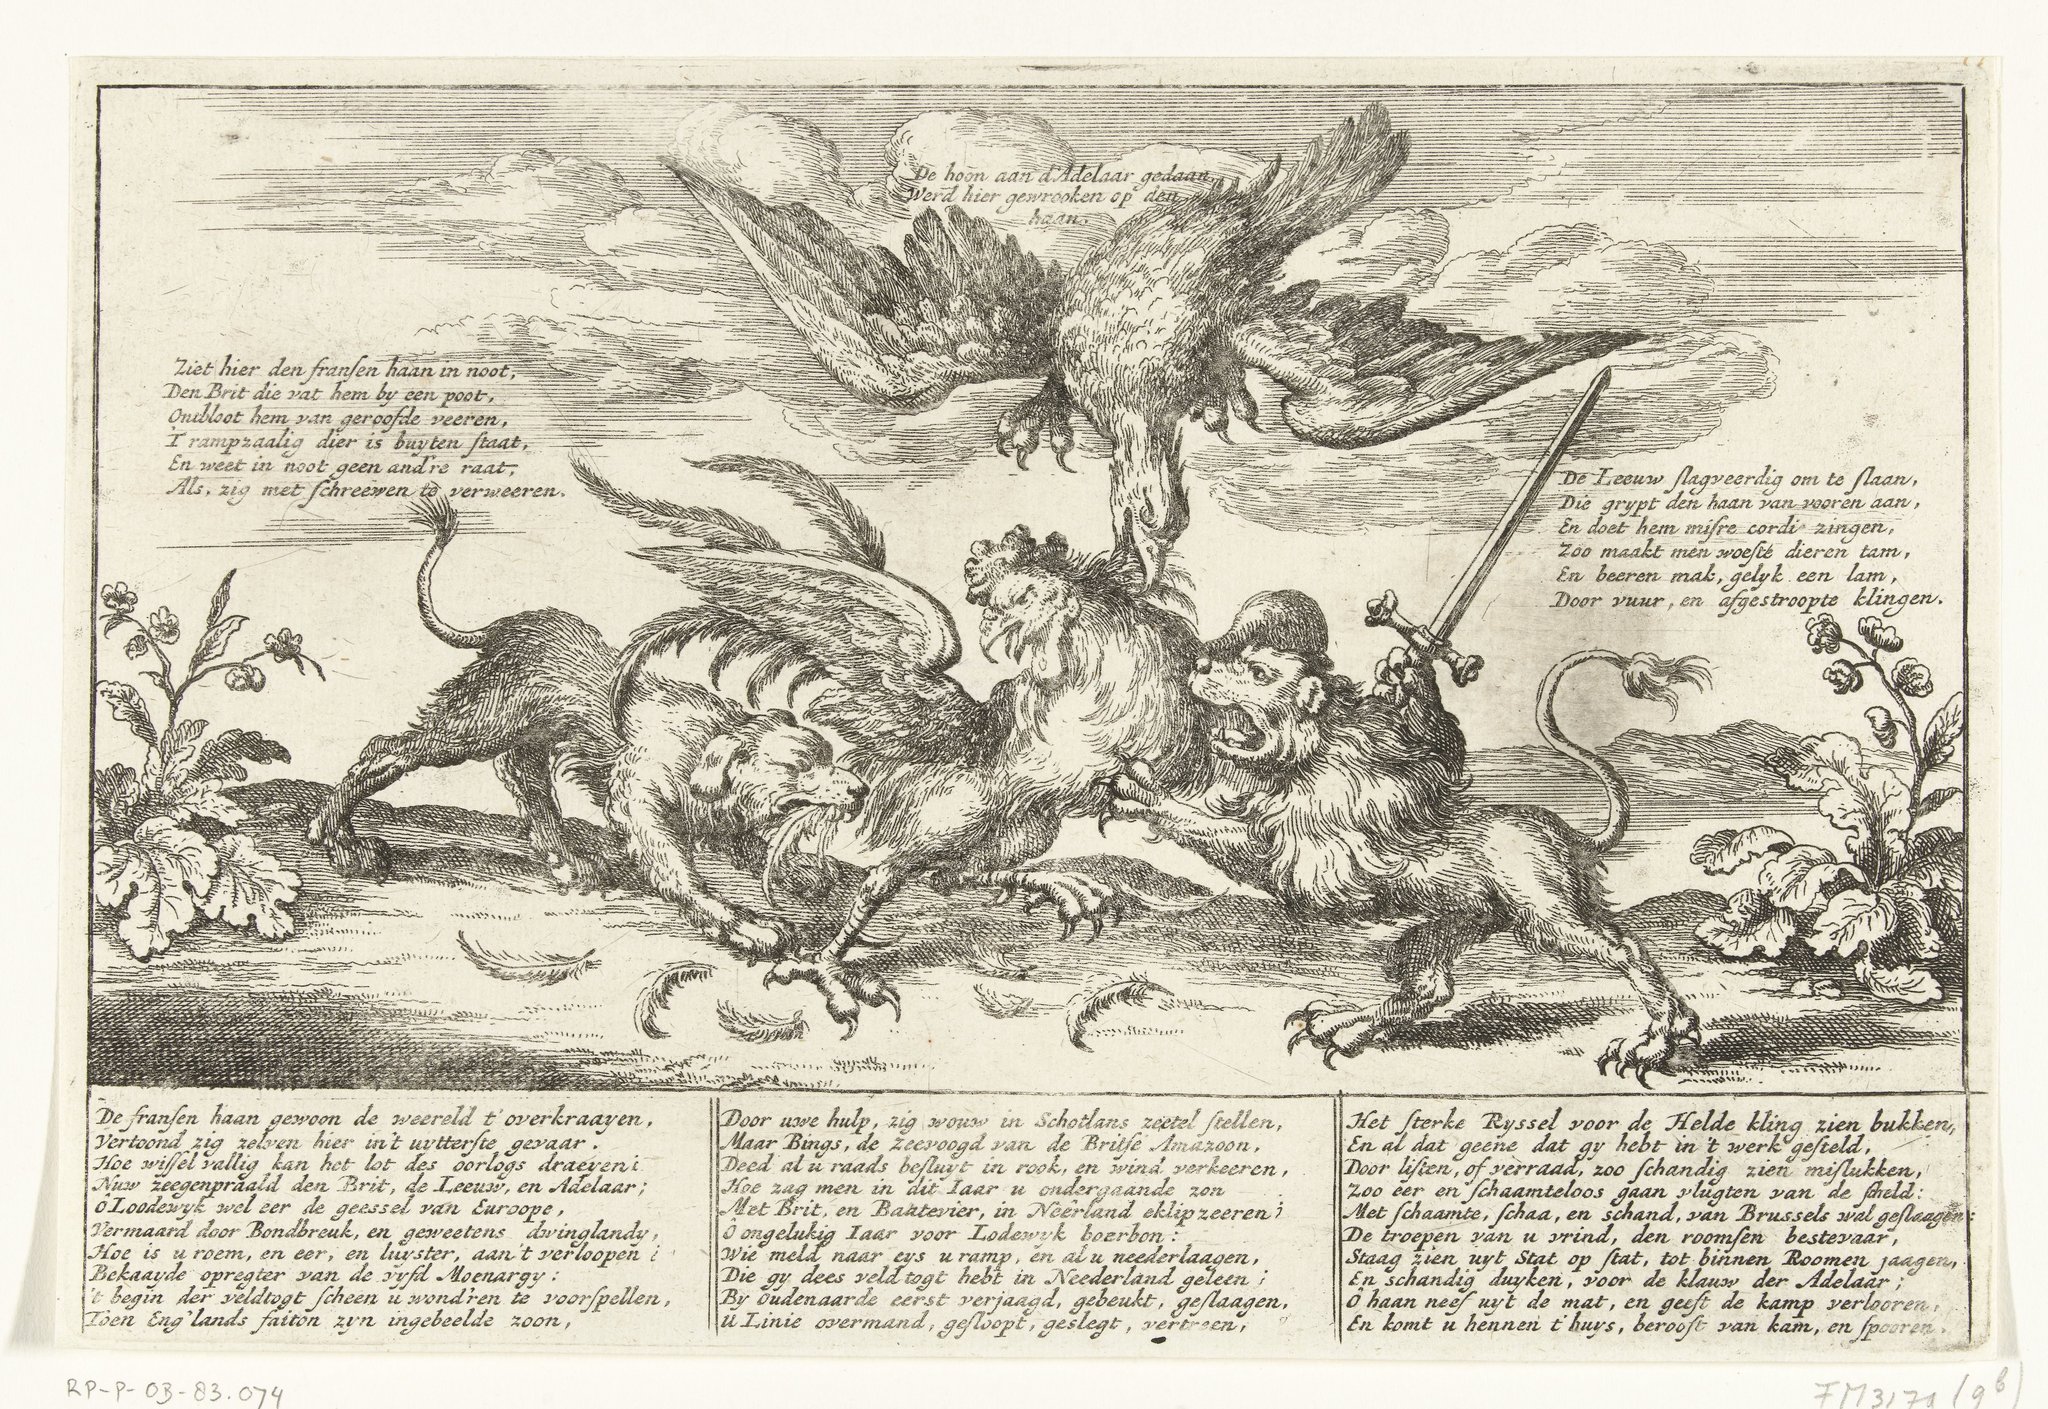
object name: cartoon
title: Franse haan aangevallen door de geallieerden, 1708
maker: carel allard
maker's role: print maker, publisher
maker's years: 1648-1709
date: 1708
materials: paper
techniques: etching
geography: amsterdam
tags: spaanse successieoorlog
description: Spotprent met de Franse haan aangevallen door de geallieerden: de hond (Engeland), de Nederlandse Leeuw en de keizerlijke adelaar. Alle verzen en opschriften in de plaat in het Nederlands. Onderdeel van een reeks getiteld Palmhof der Bondgenooten met 9 spotprenten op de Fransen en bondgenoten uit het jaar 1708.